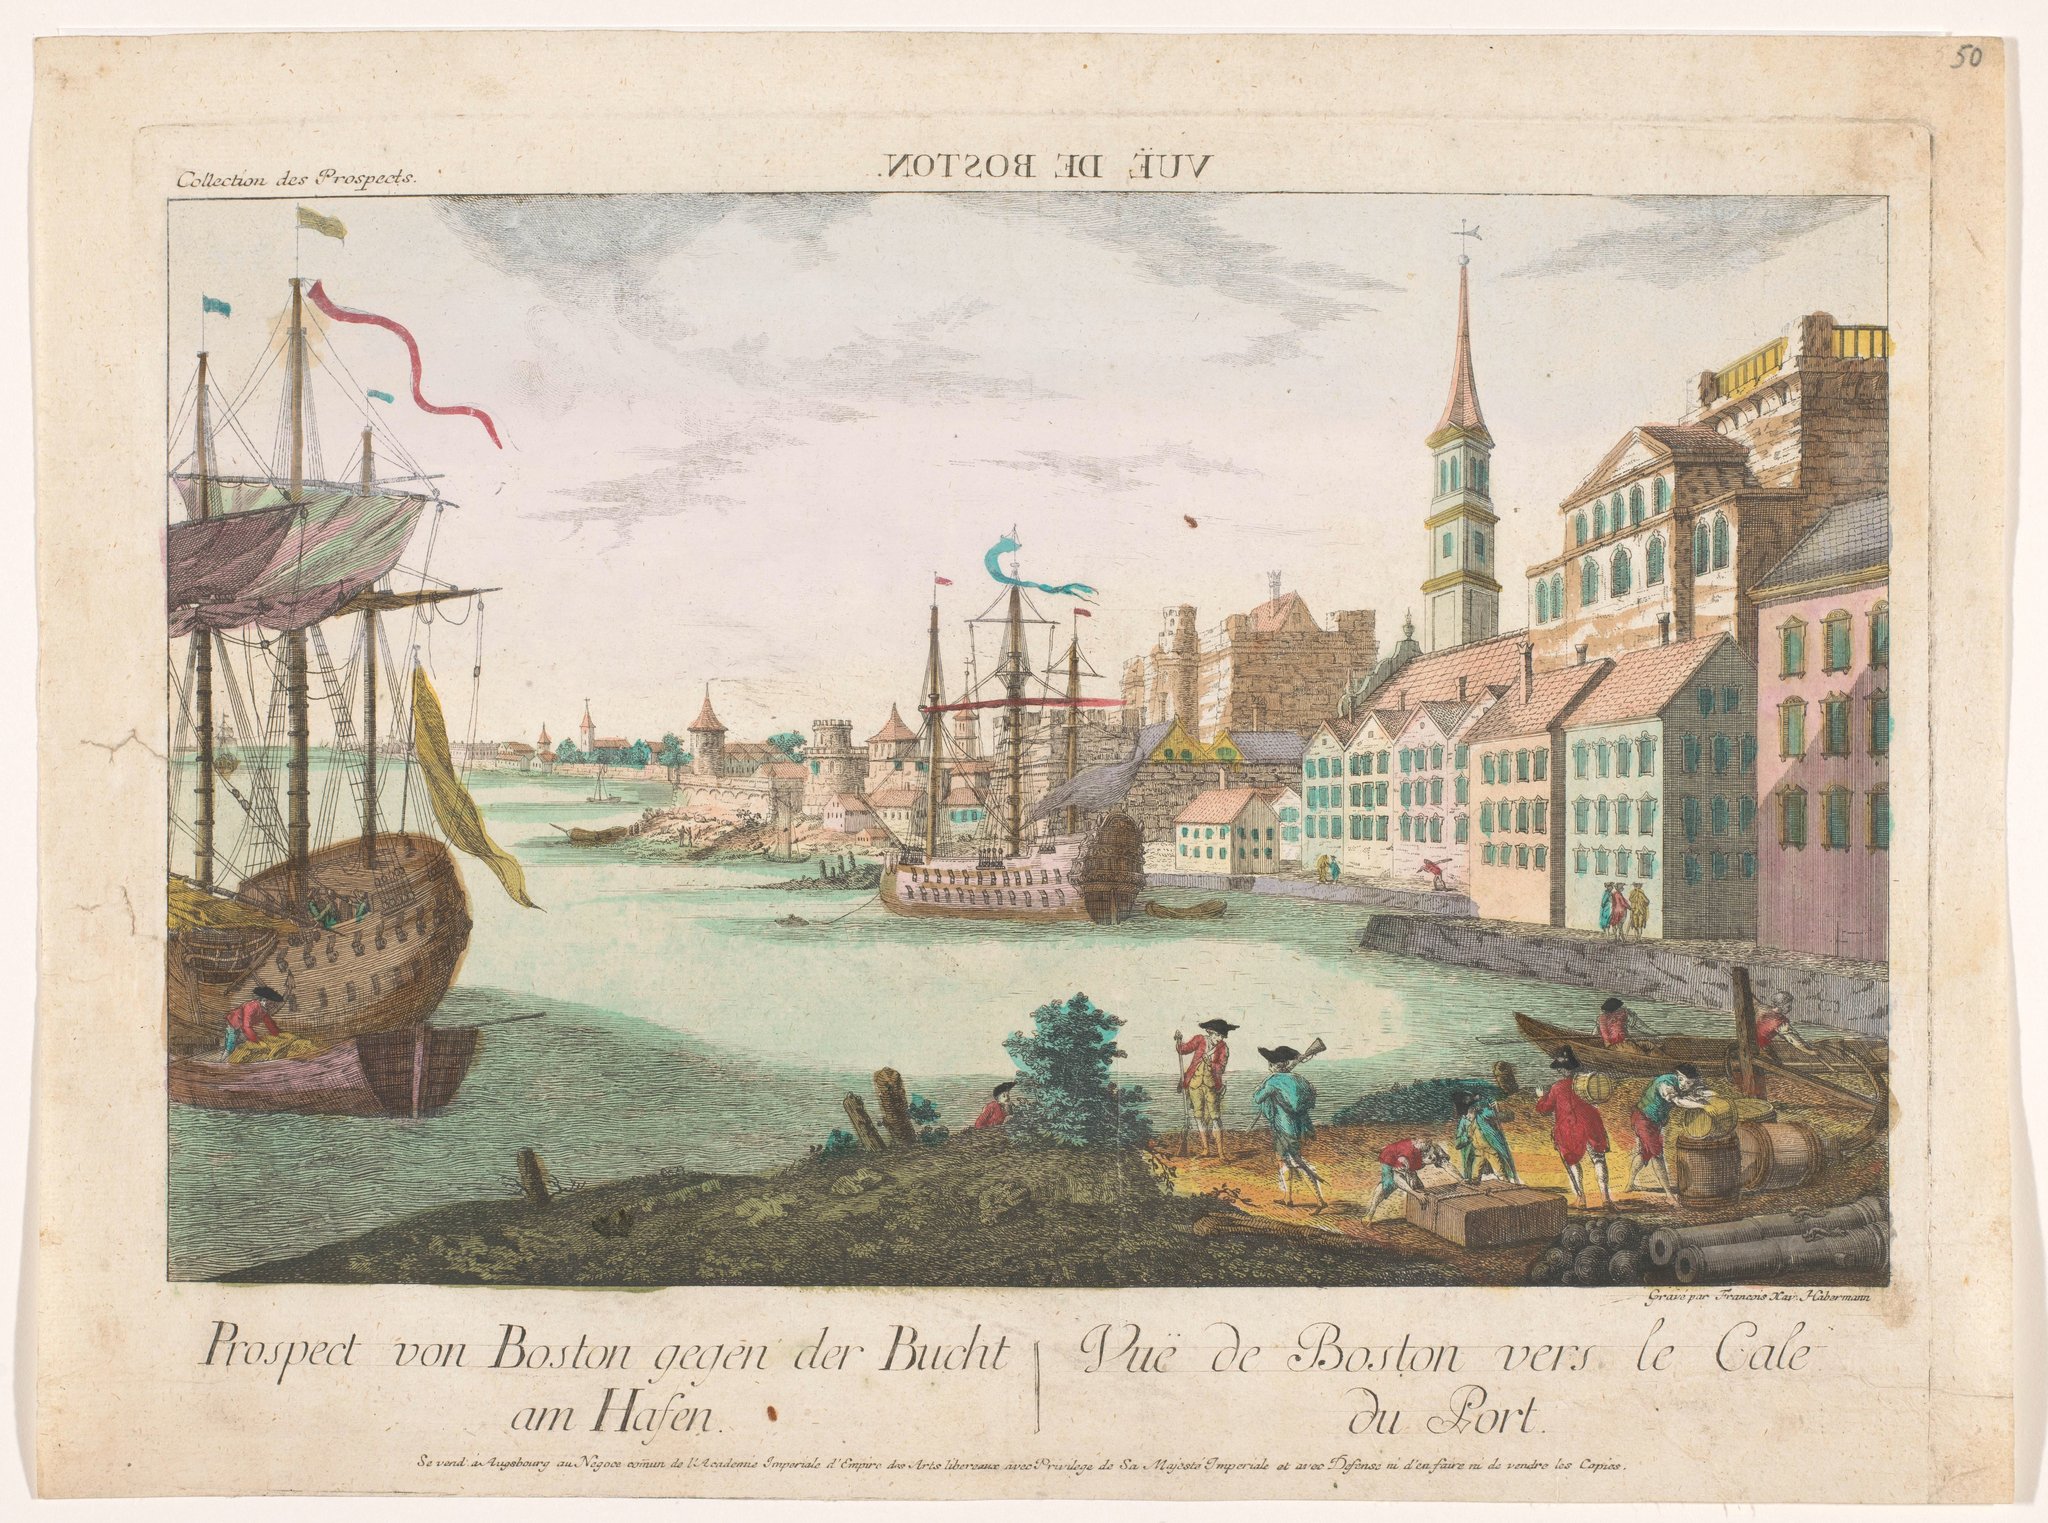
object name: print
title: Prospect von Boston gegen der Bucht am Hafen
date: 1755-1779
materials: paper, watercolor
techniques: brush, etching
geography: augsburg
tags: harbour, sailing-ship, sailing-boat, castle, rowing-boat, canoe, etc.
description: Op de voorgrond staan figuren met goederen aan de waterkant. Op de achtergrond een versterkt bouwwerk.